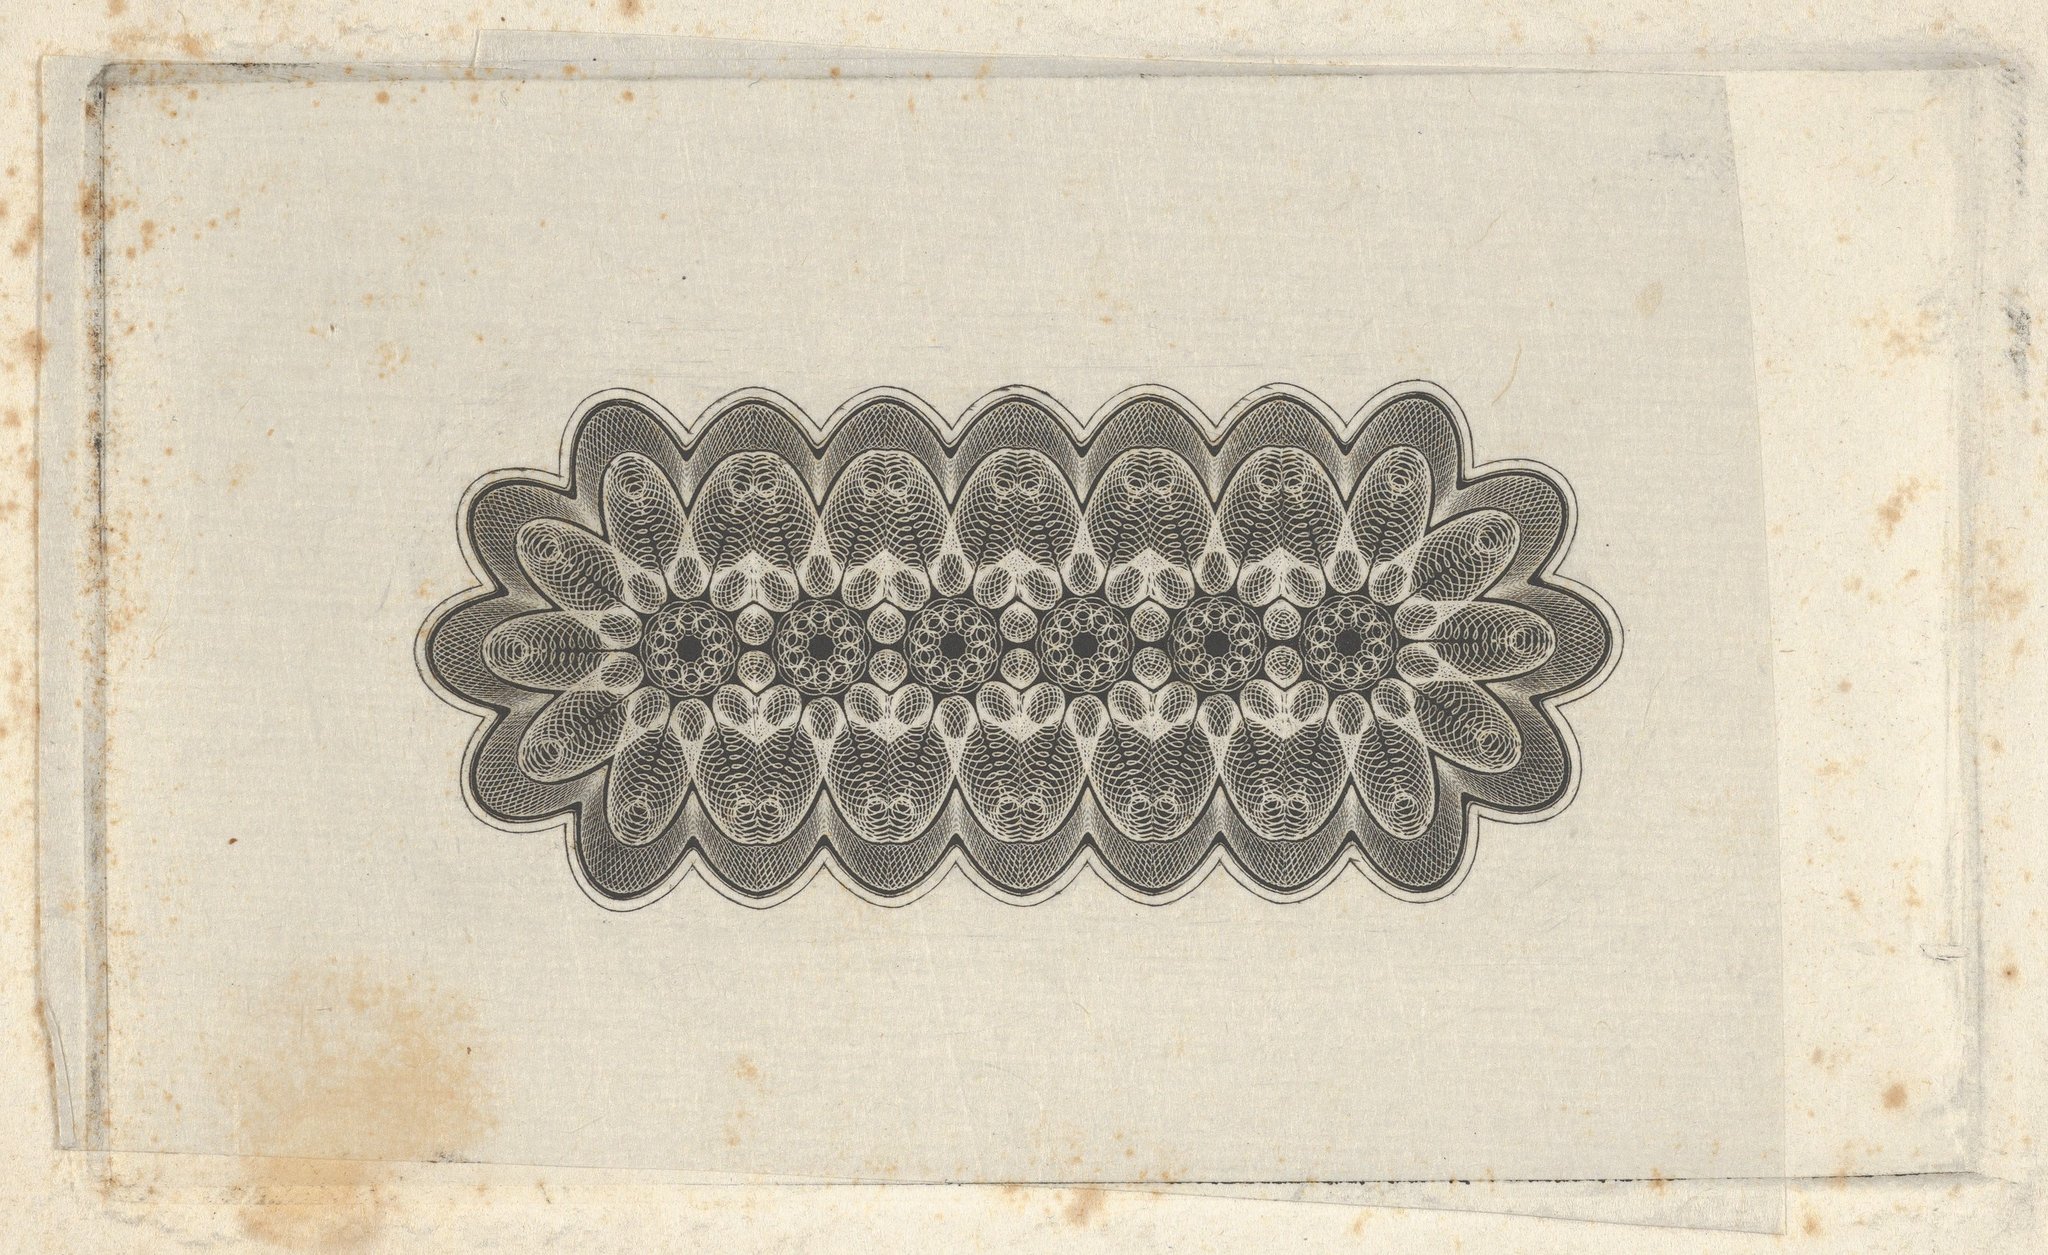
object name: print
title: Banknote motifs: panel of lathe work ornament with rounded ends, with a repeating floral pattern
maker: cyrus durand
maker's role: artist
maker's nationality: american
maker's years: 1787-1868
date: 1824-1842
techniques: printmaking, engraving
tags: flowers